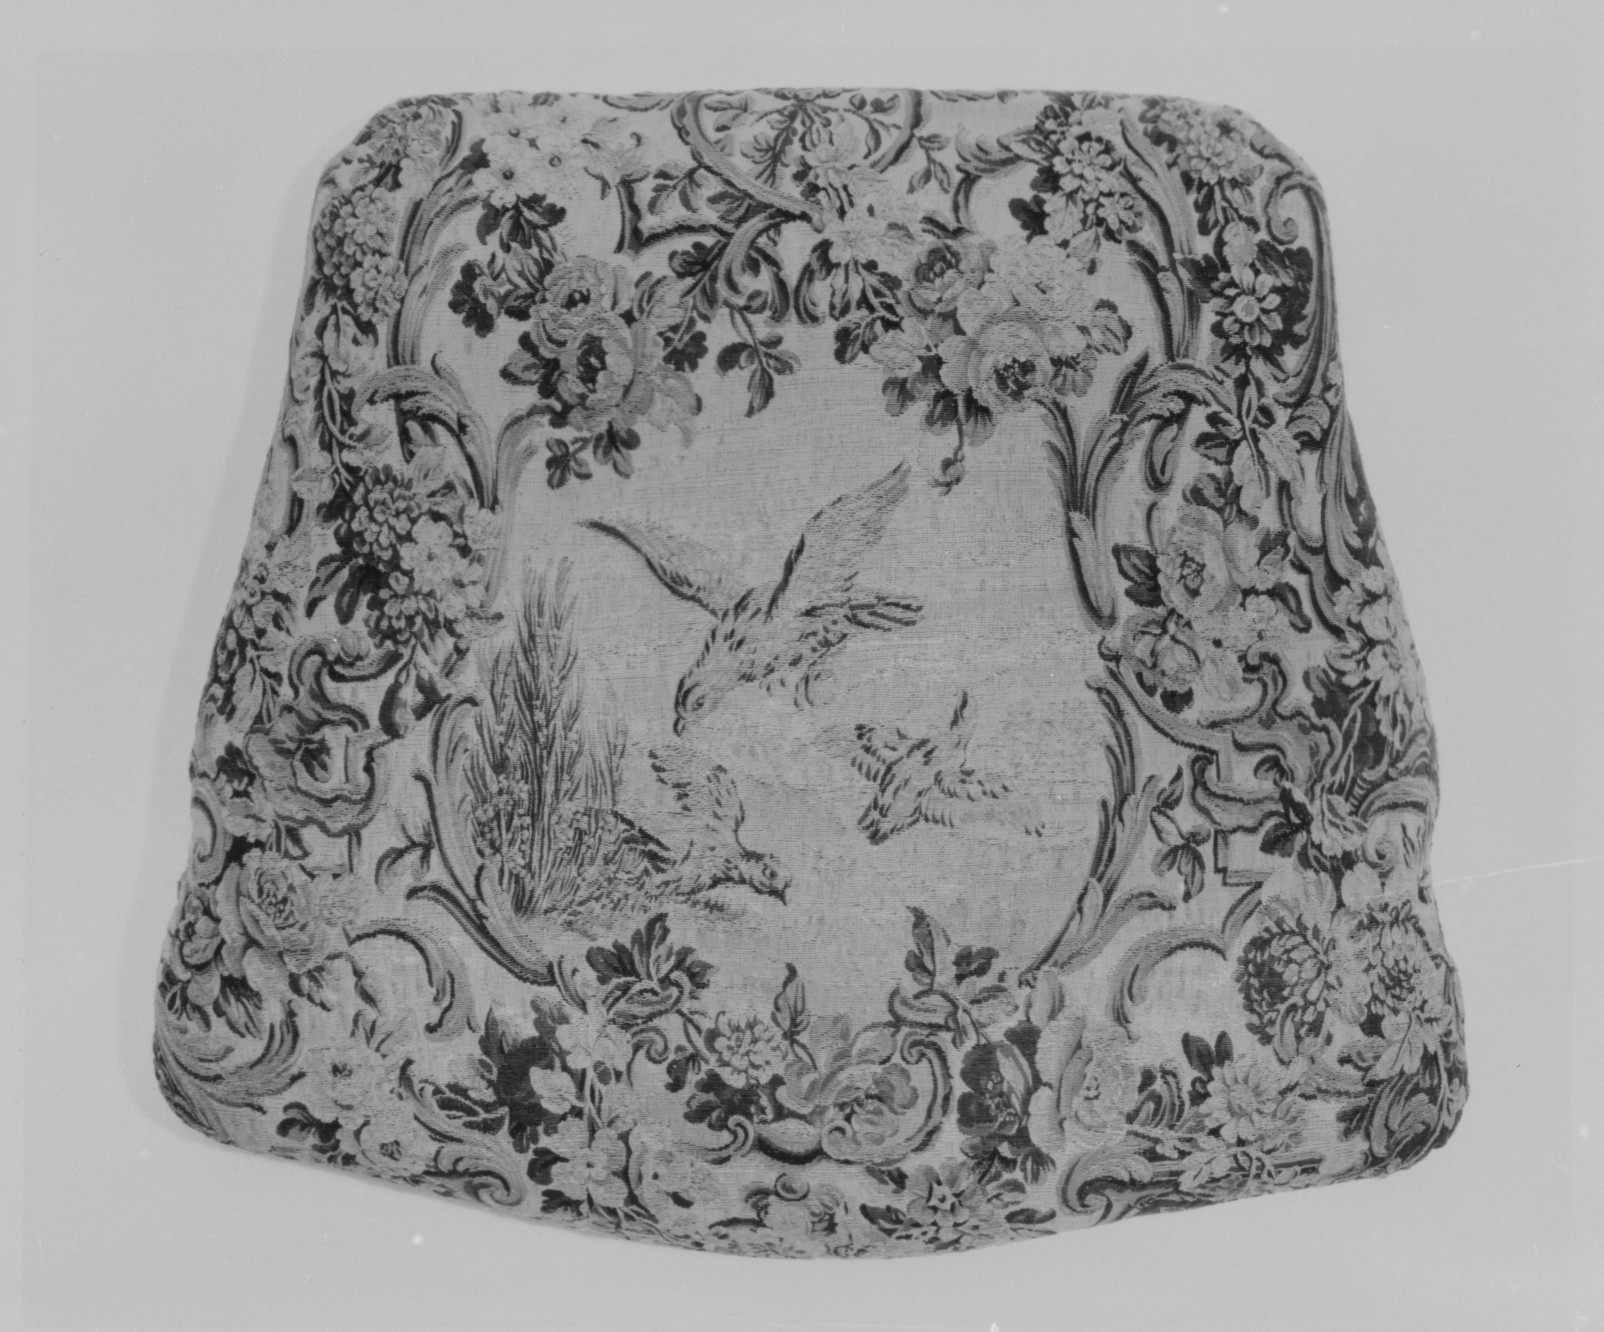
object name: upholstery panel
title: Armchair seat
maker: beauvais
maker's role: manufactory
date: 1754-1756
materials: silk, wool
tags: birds,flowers,plants